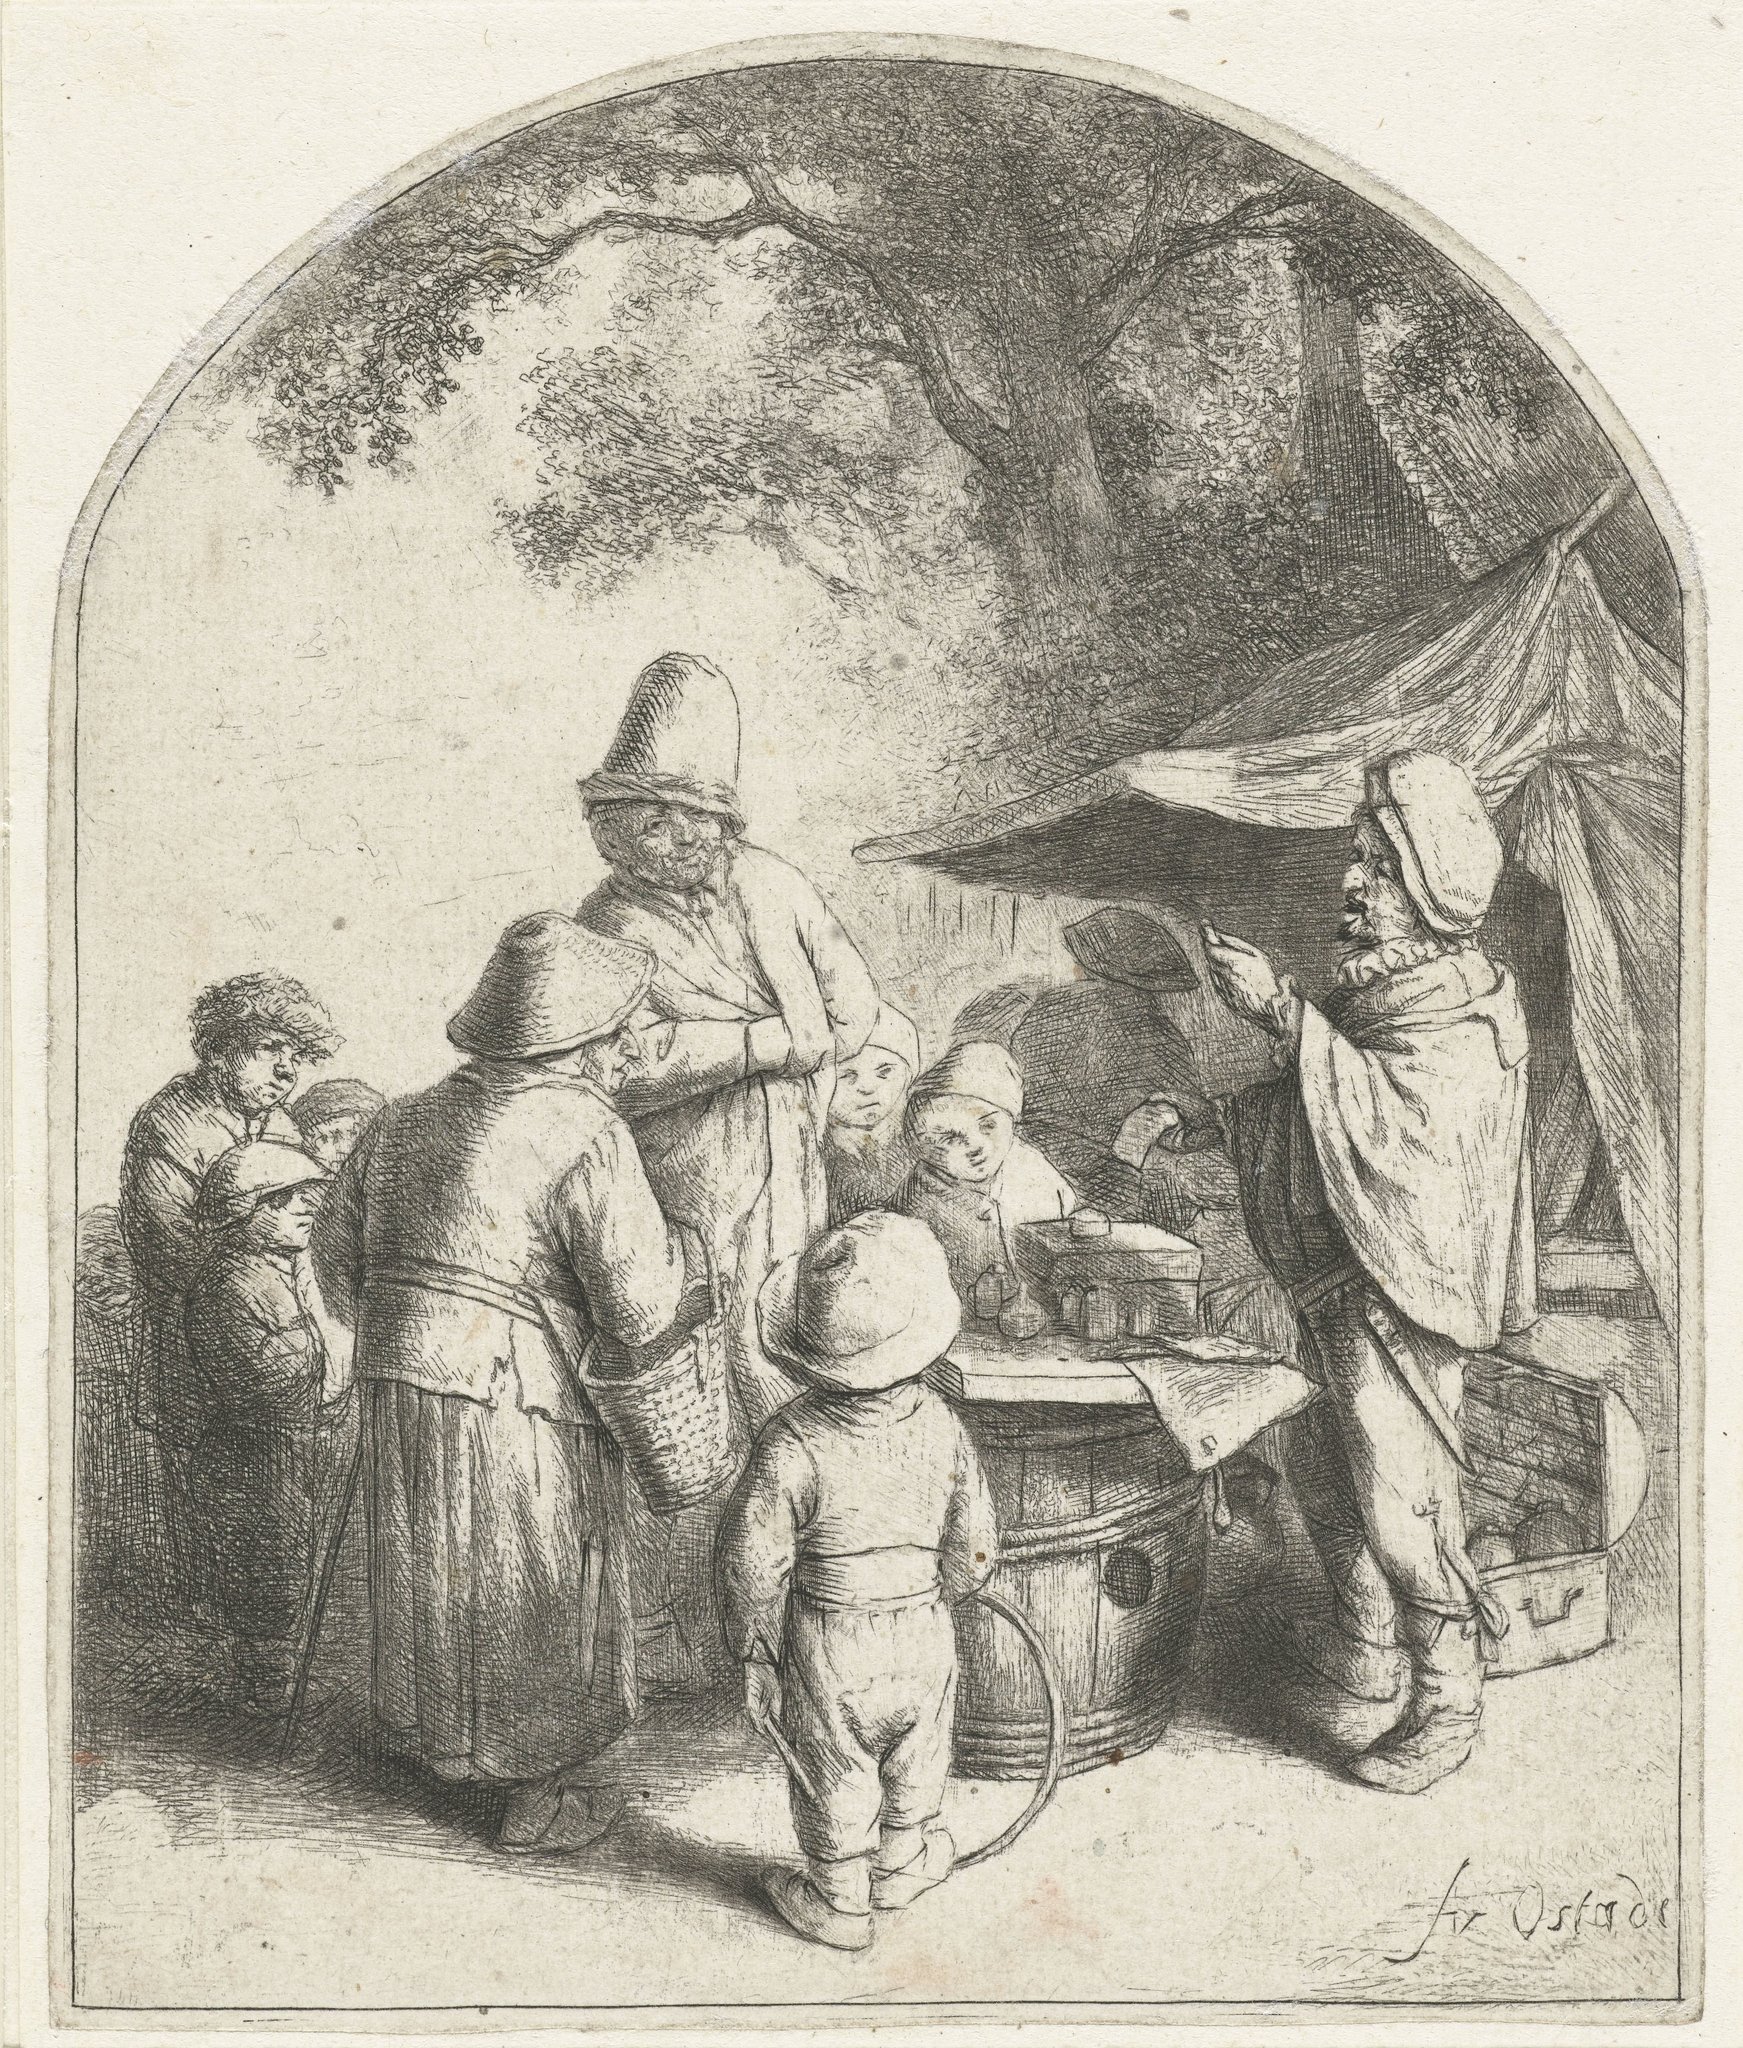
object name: print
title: Kwakzalver verkoopt zijn waren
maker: adriaen van ostade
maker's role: draughtsman, painter, print maker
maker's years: 1610-1685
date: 1648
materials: paper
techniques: etching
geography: haarlem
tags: quack, charlatan, mountebank, 'saltimbanco'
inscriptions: collector's mark: Lugt 240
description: Enkele volwassenen en kinderen luisteren naar het verhaal van een kwakzalver die zijn waren probeert te slijten vlakbij een grote boom en tent . Op de voorgrond staat een kleine jongen met een hoepel te kijken met de rug naar de beschouwer toe. De voorstelling heeft een halfronde bovenkant.